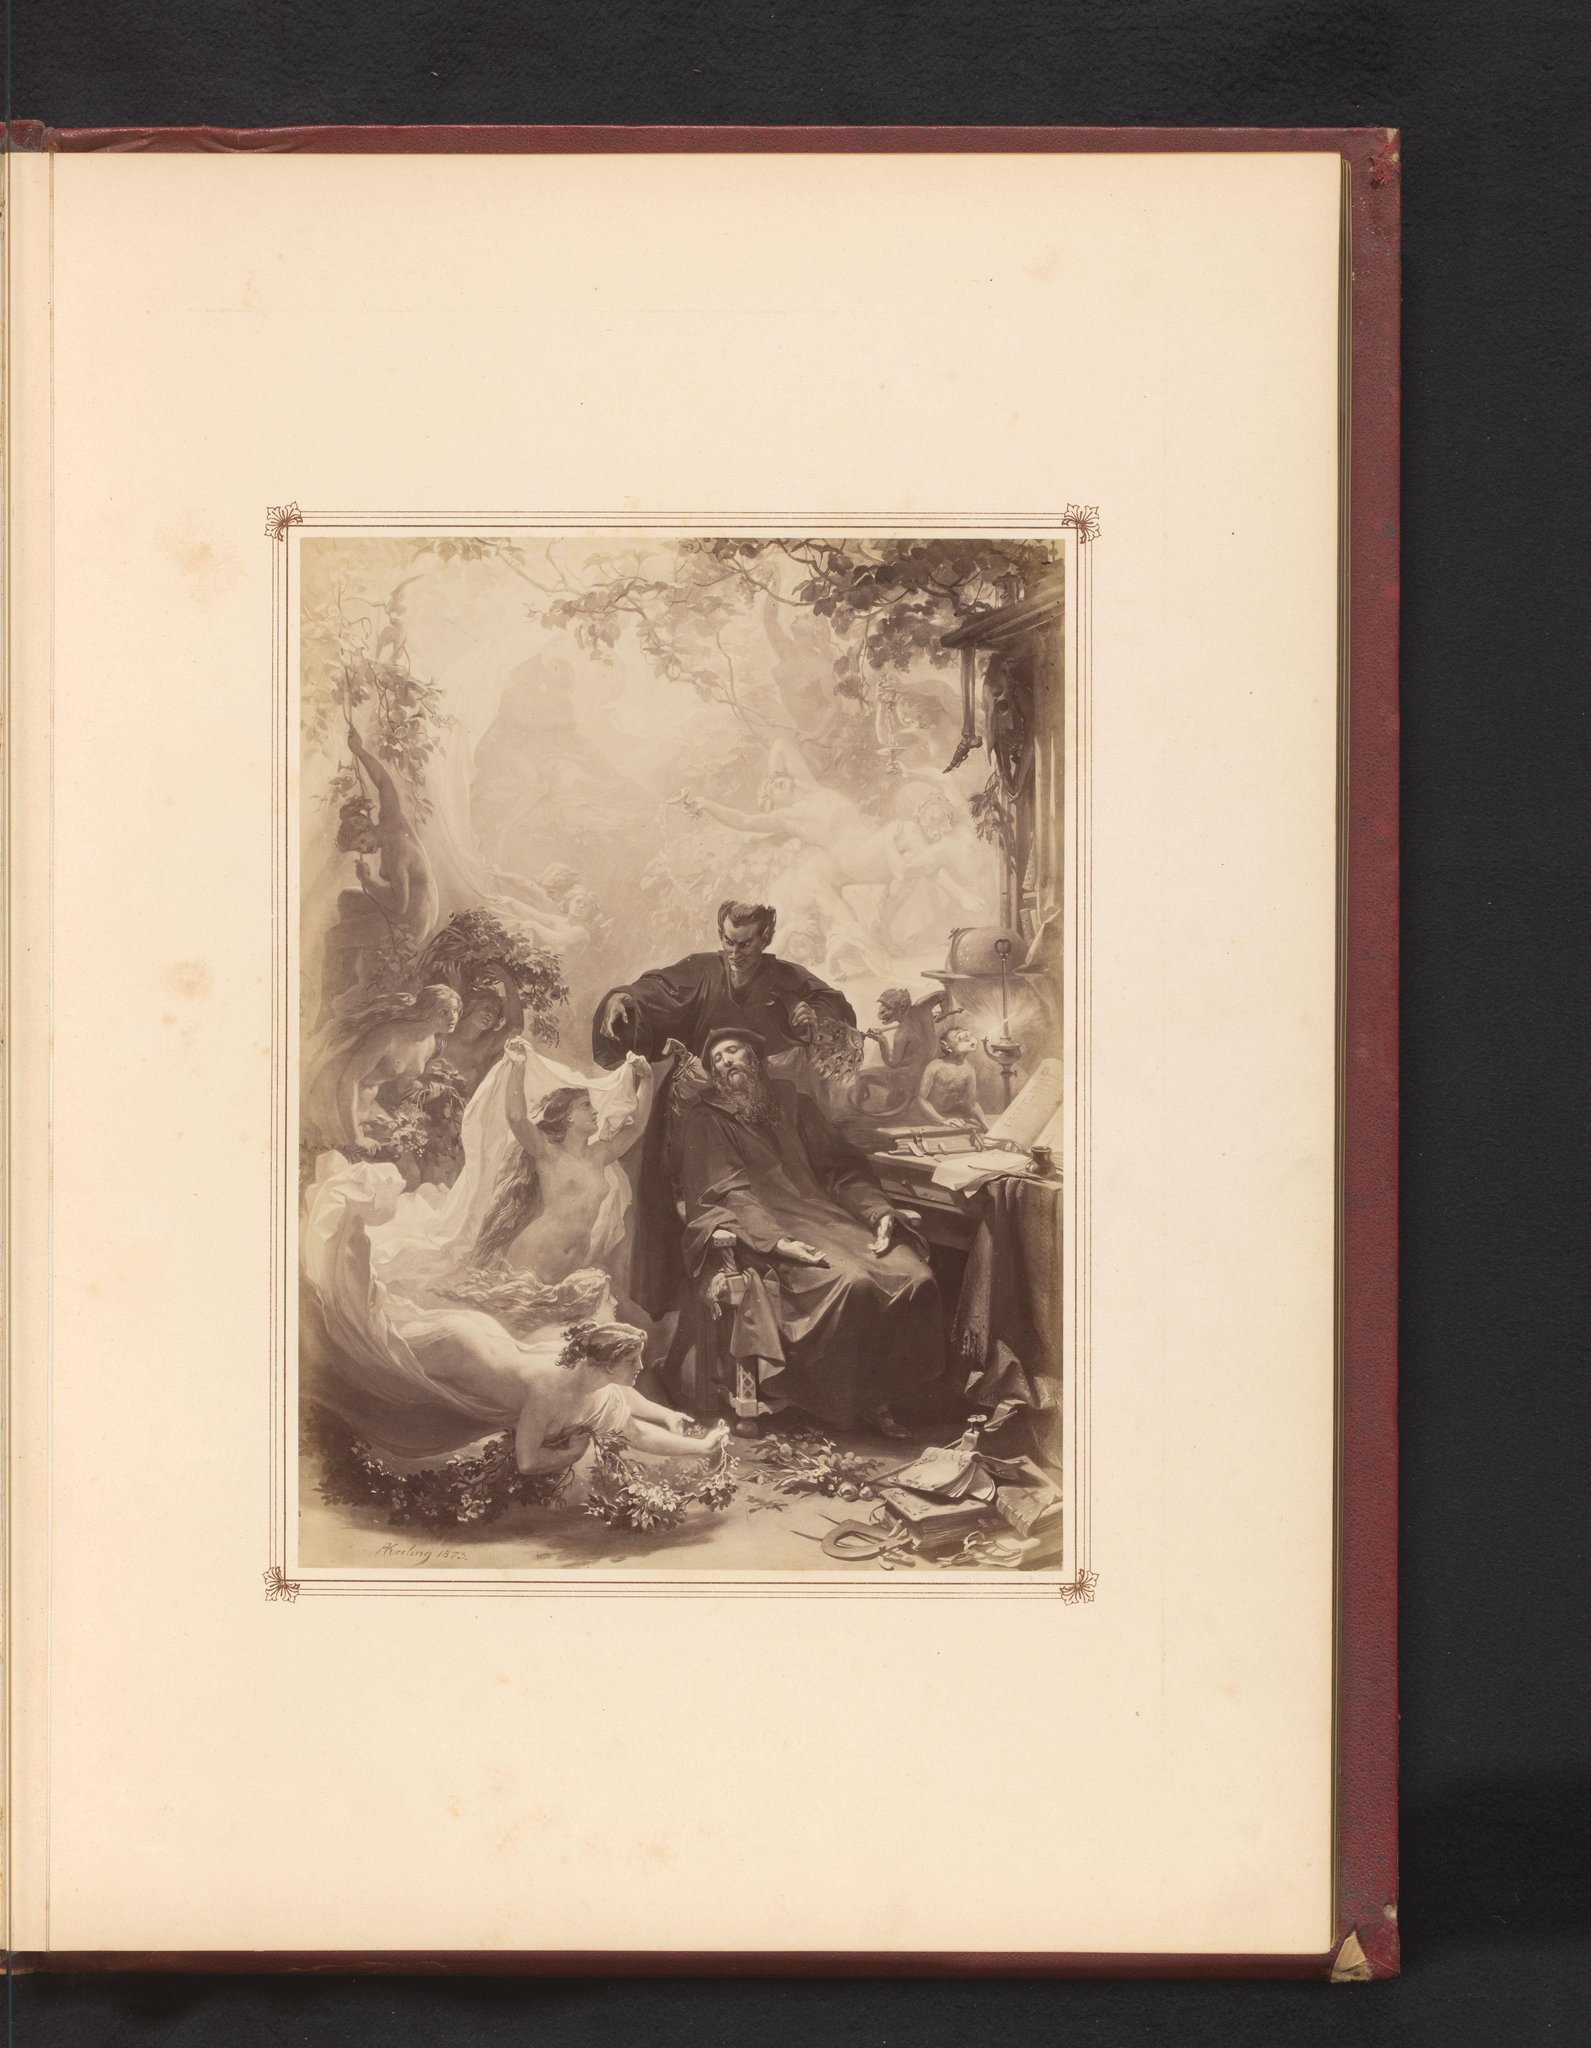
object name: reproduction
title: Fotoreproductie van een tekening van Mephistopheles die aan Faust verschijnt, uit het eerste deel van de tragedie Faust door Johann Wolfgang von Goethe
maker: friedrich bruckmann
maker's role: publisher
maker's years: 1814-1898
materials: photographic support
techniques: albumen print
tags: mephistopheles, name of the demonic tempter in the literary versions of the faust legends, (scenes from) specific works of literature: goethe, faust